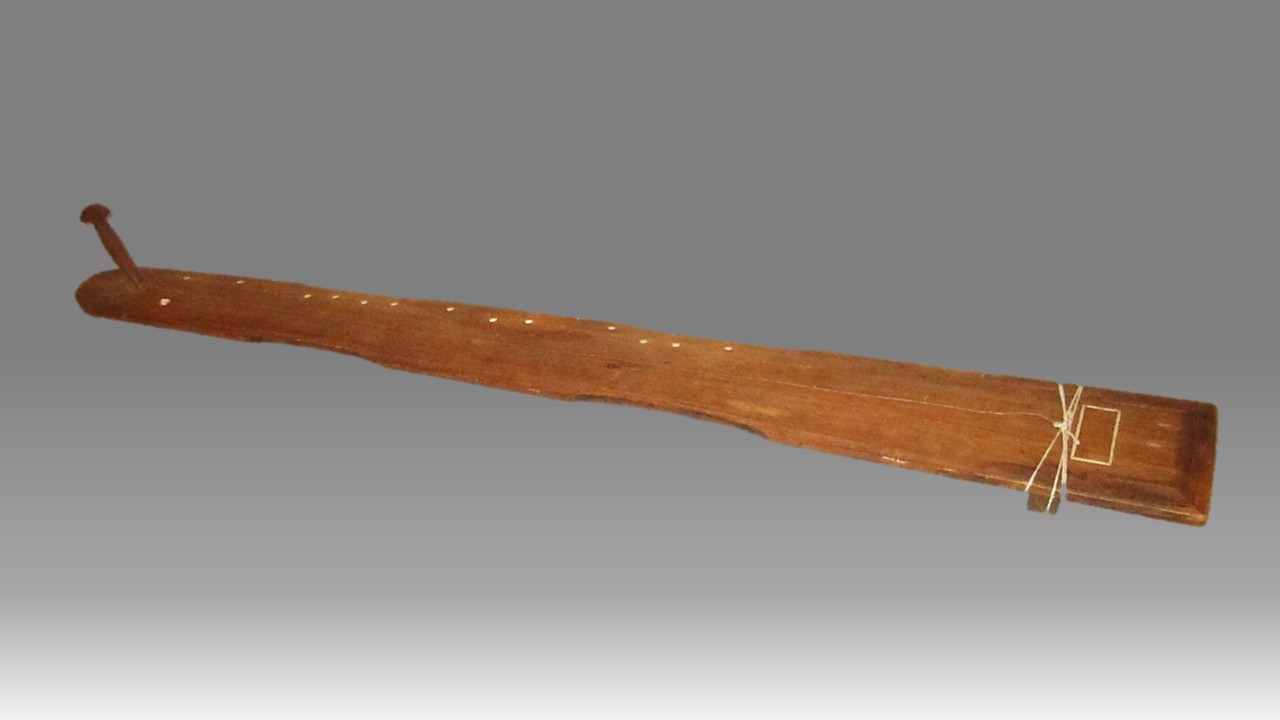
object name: ichigen kin 一絃琴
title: Ichigen-kin (一絃琴)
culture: japanese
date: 1801-1900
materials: wood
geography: japan